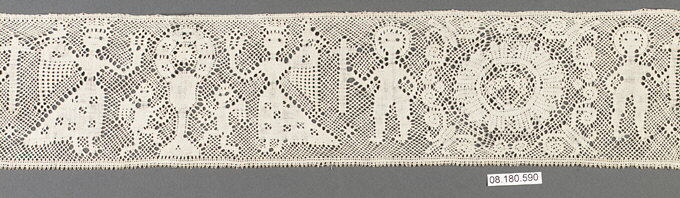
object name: border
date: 1701-1800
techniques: lace